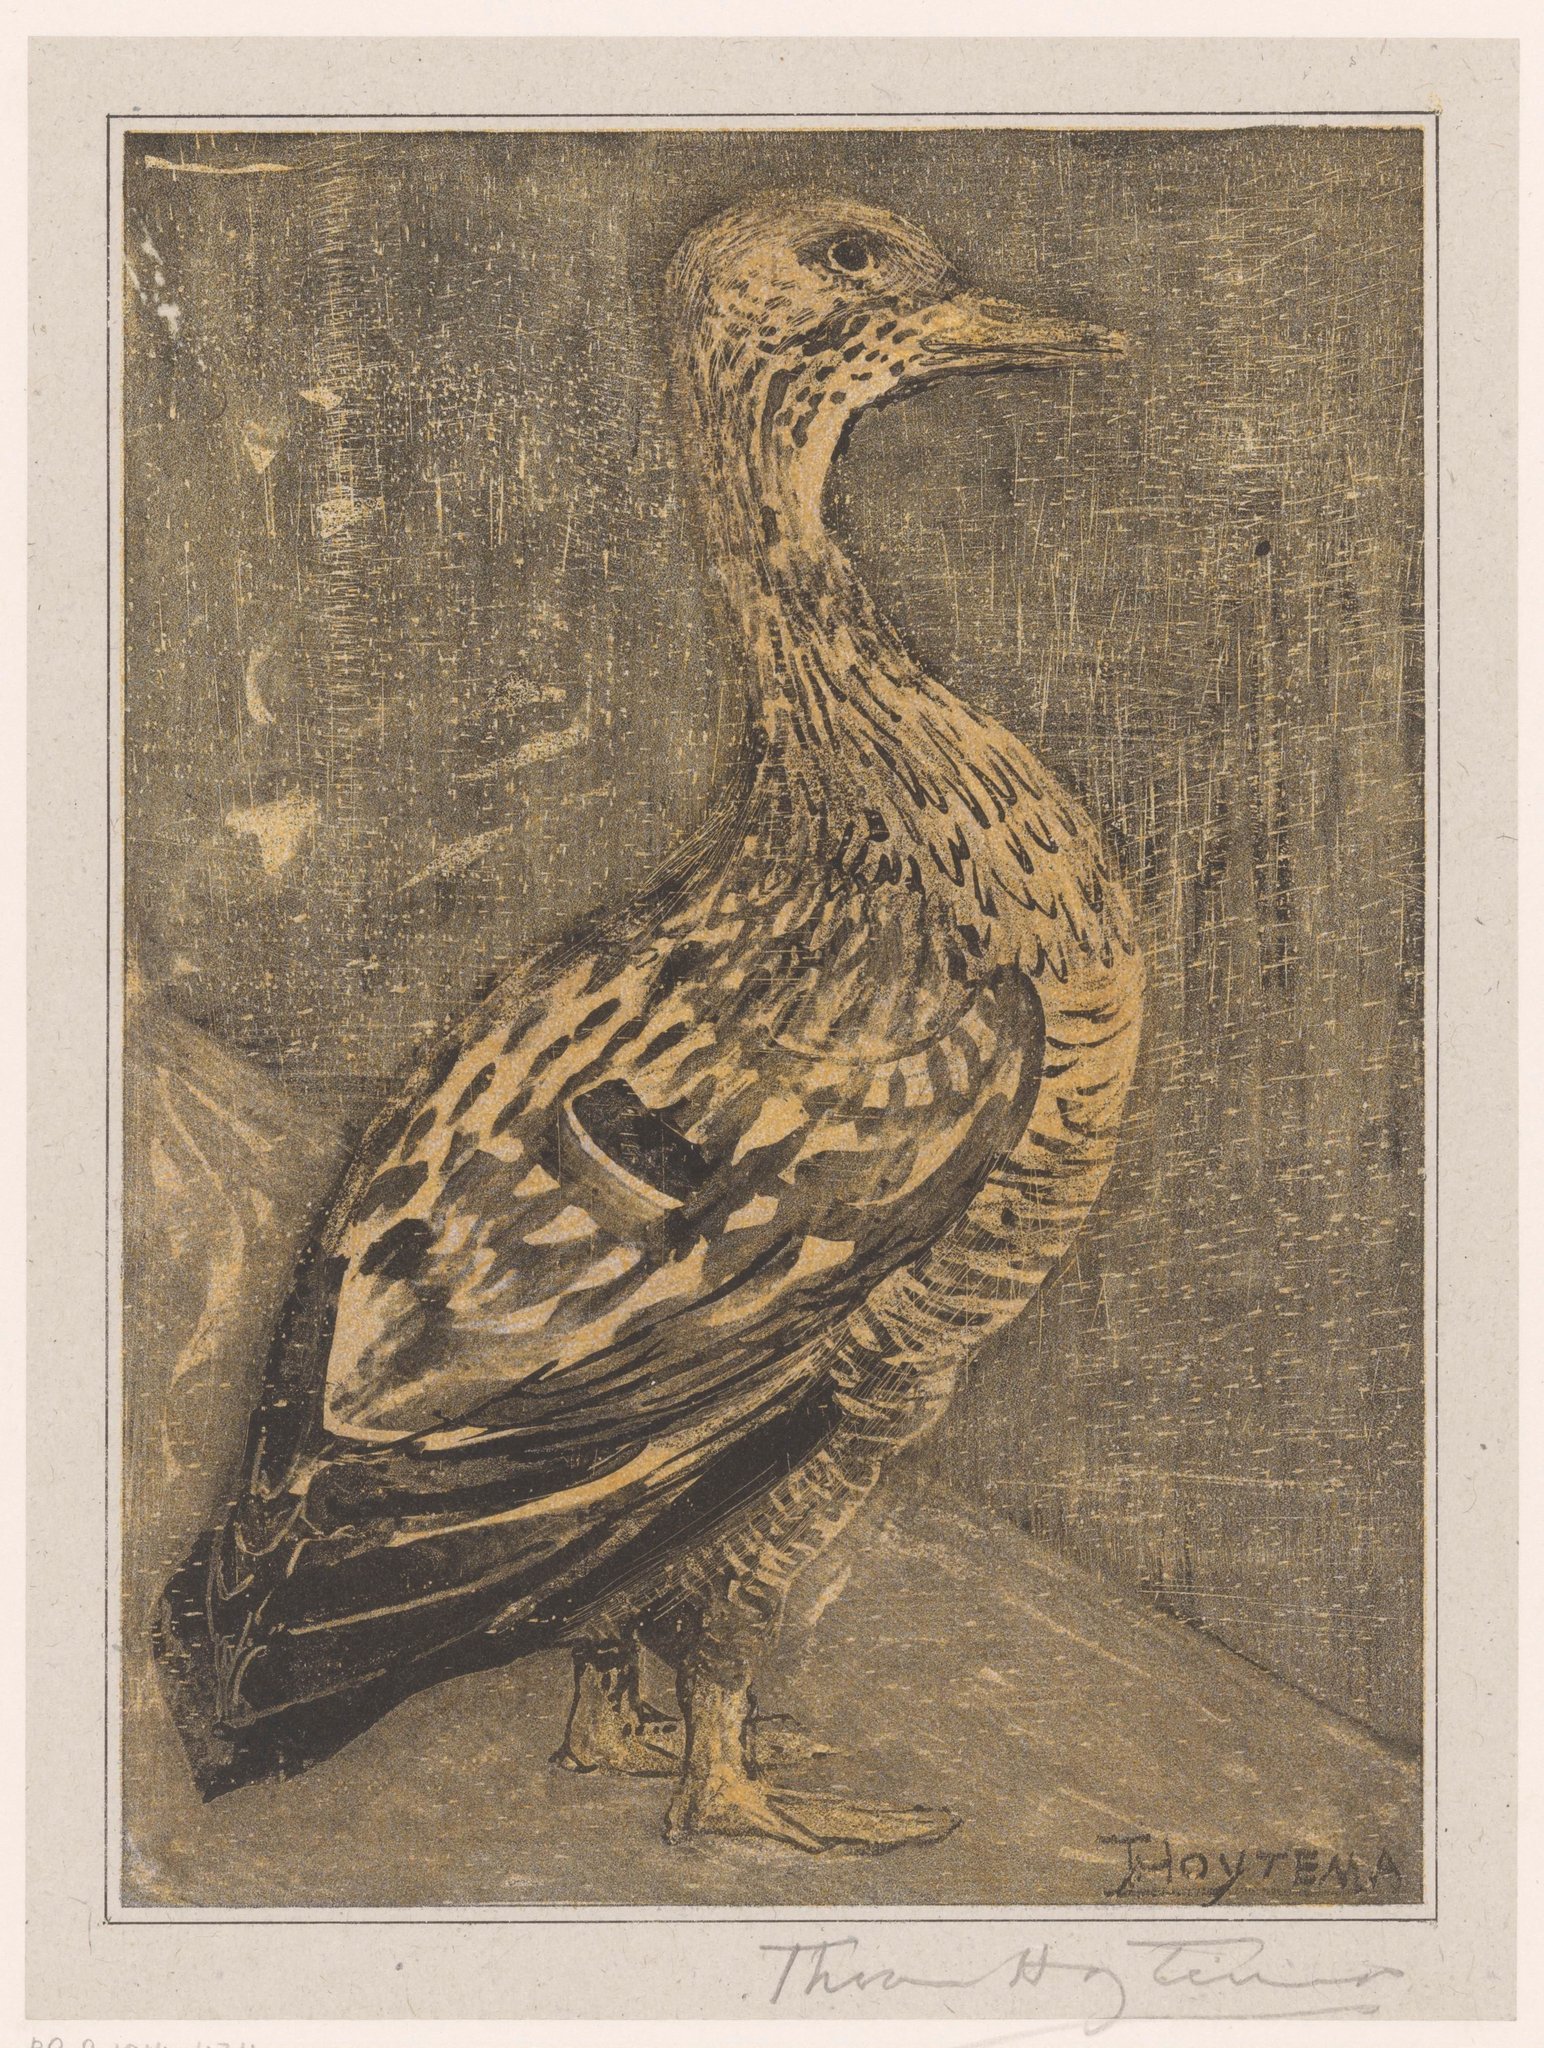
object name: print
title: Staande eend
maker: theo van hoytema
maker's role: draughtsman, painter, print maker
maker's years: 1863-1917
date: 1878-1909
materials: paper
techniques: lithograph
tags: water-birds: duck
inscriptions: collector's mark: Lugt 2233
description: Prent is een proefdruk voor kalenderblad januari 1909.